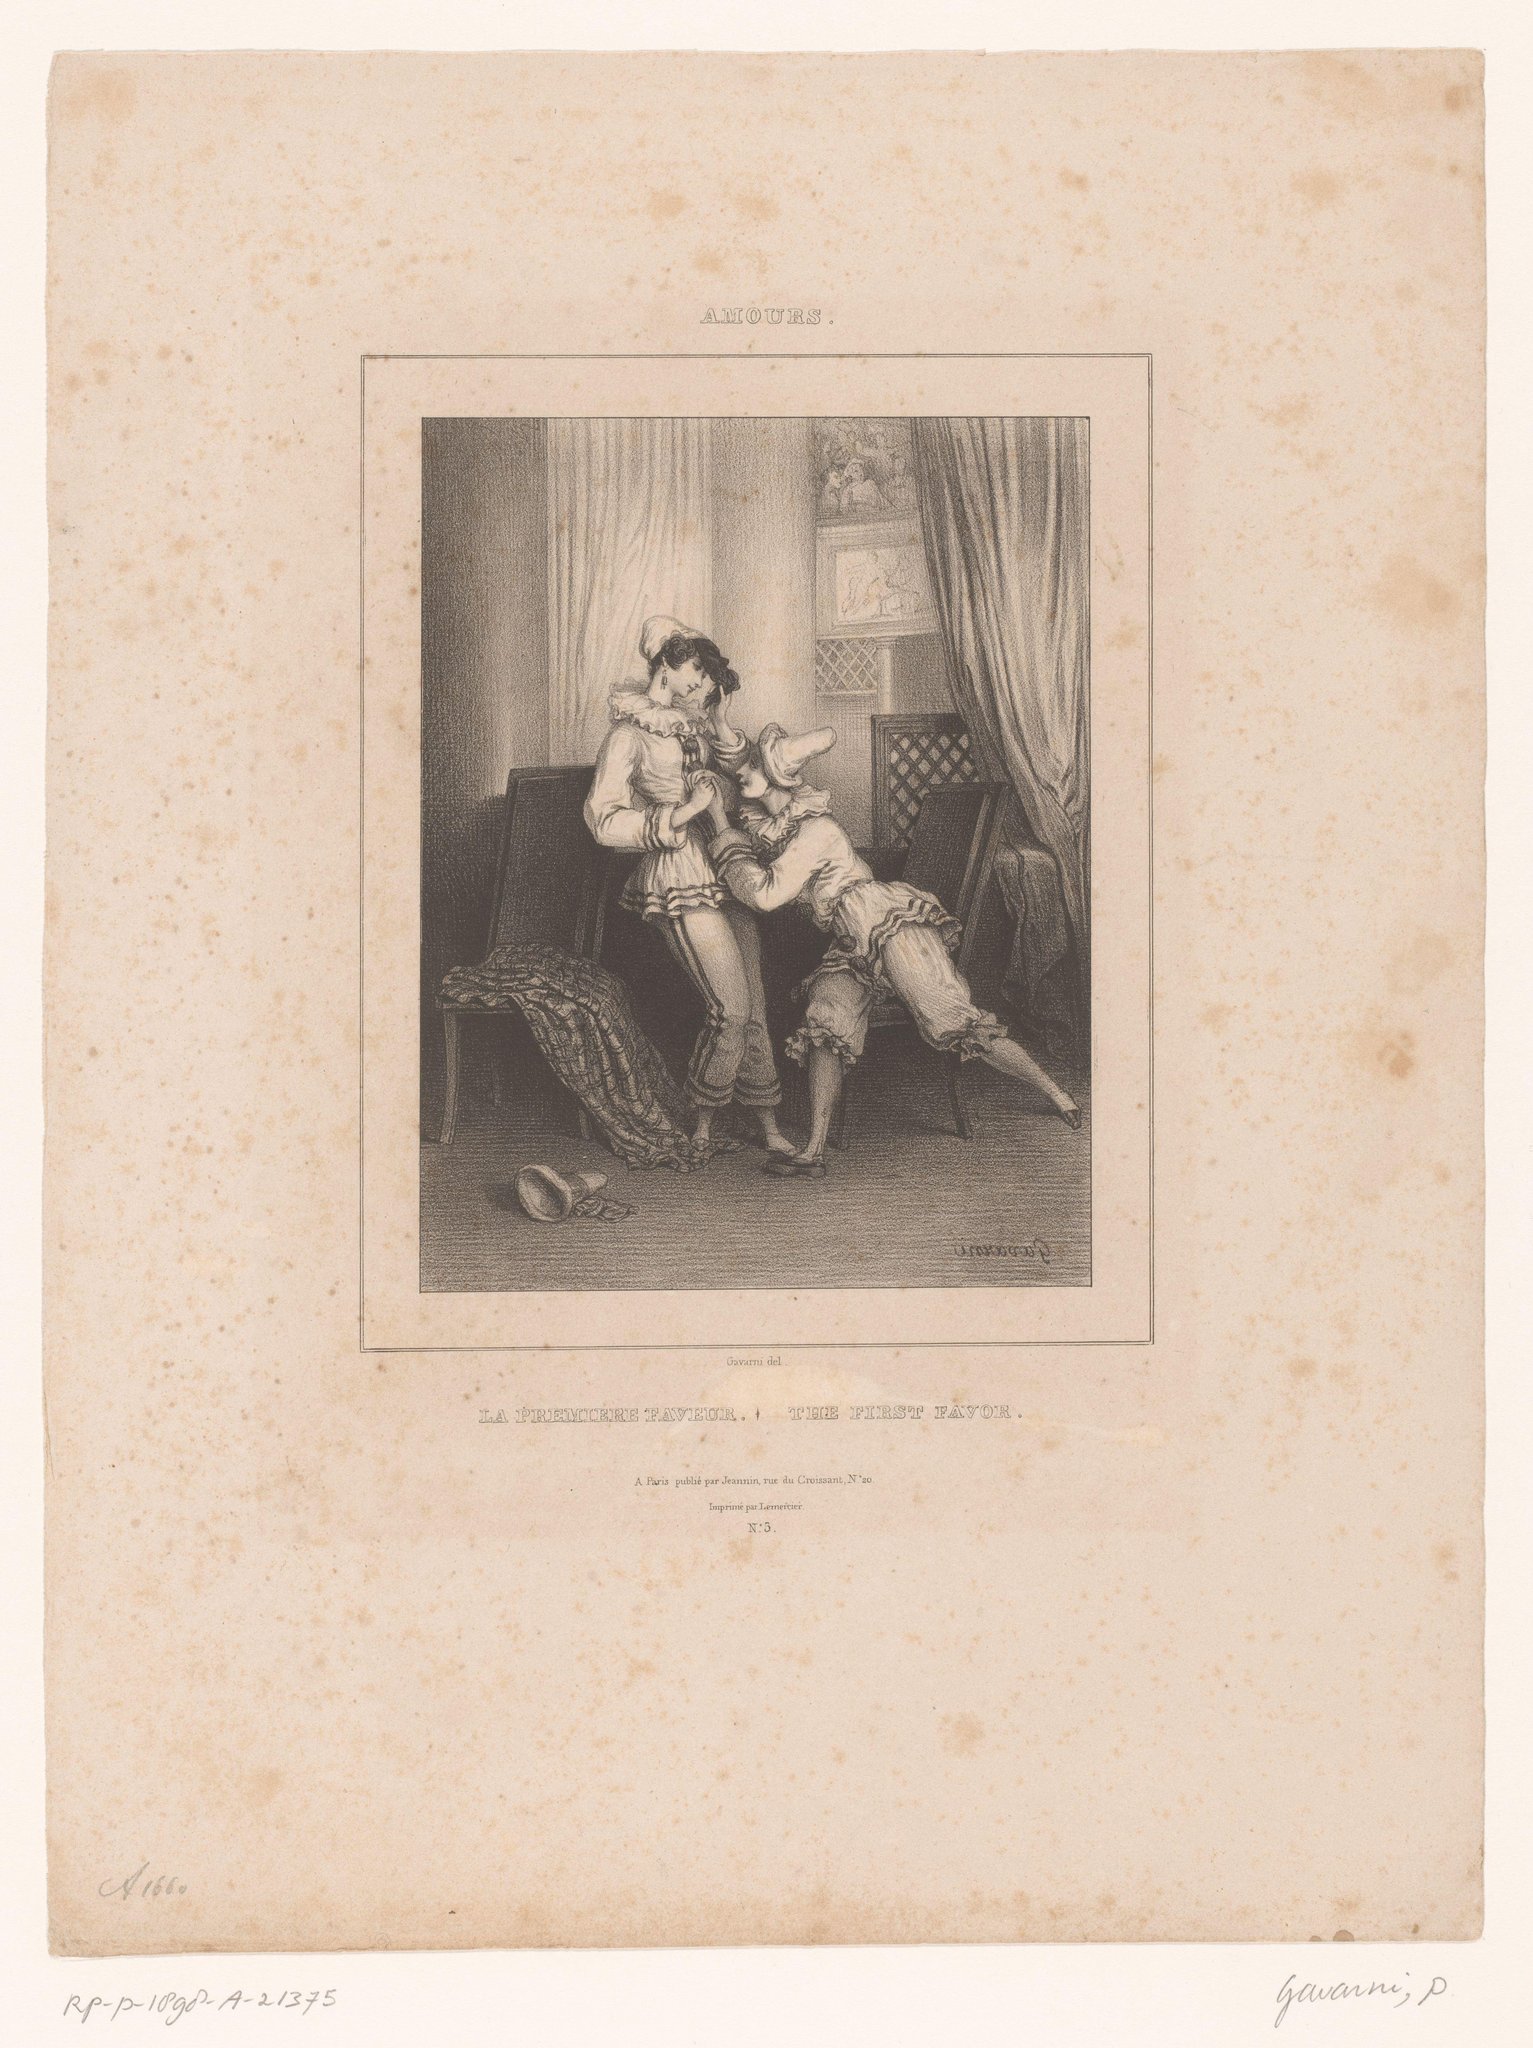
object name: print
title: La première faveur / The first favor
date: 1833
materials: paper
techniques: lithograph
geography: paris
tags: types in 'commedia dell'arte': pierrot, mask, party clothes, festive attire, lovers; courting, flirting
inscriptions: collector's mark: Lugt 964, check stamp: Lugt 3987